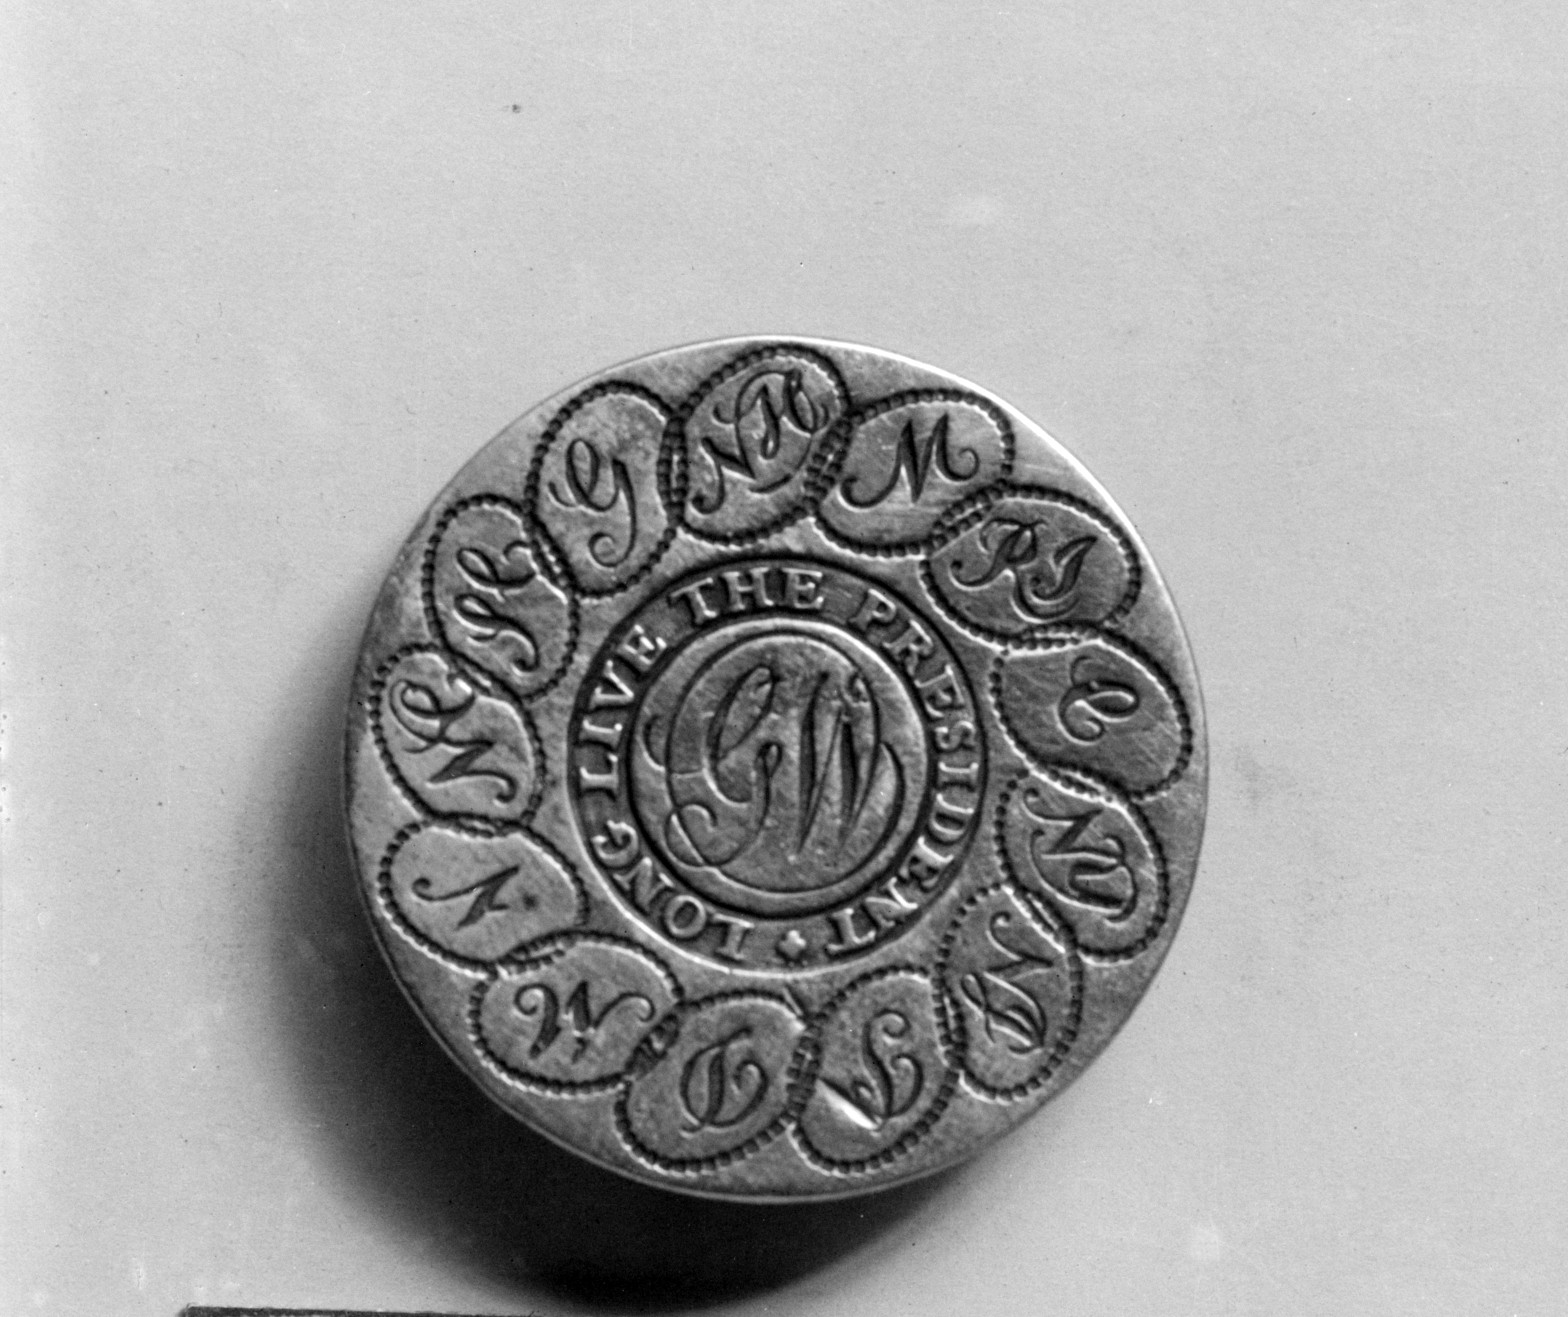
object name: button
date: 1789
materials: brass